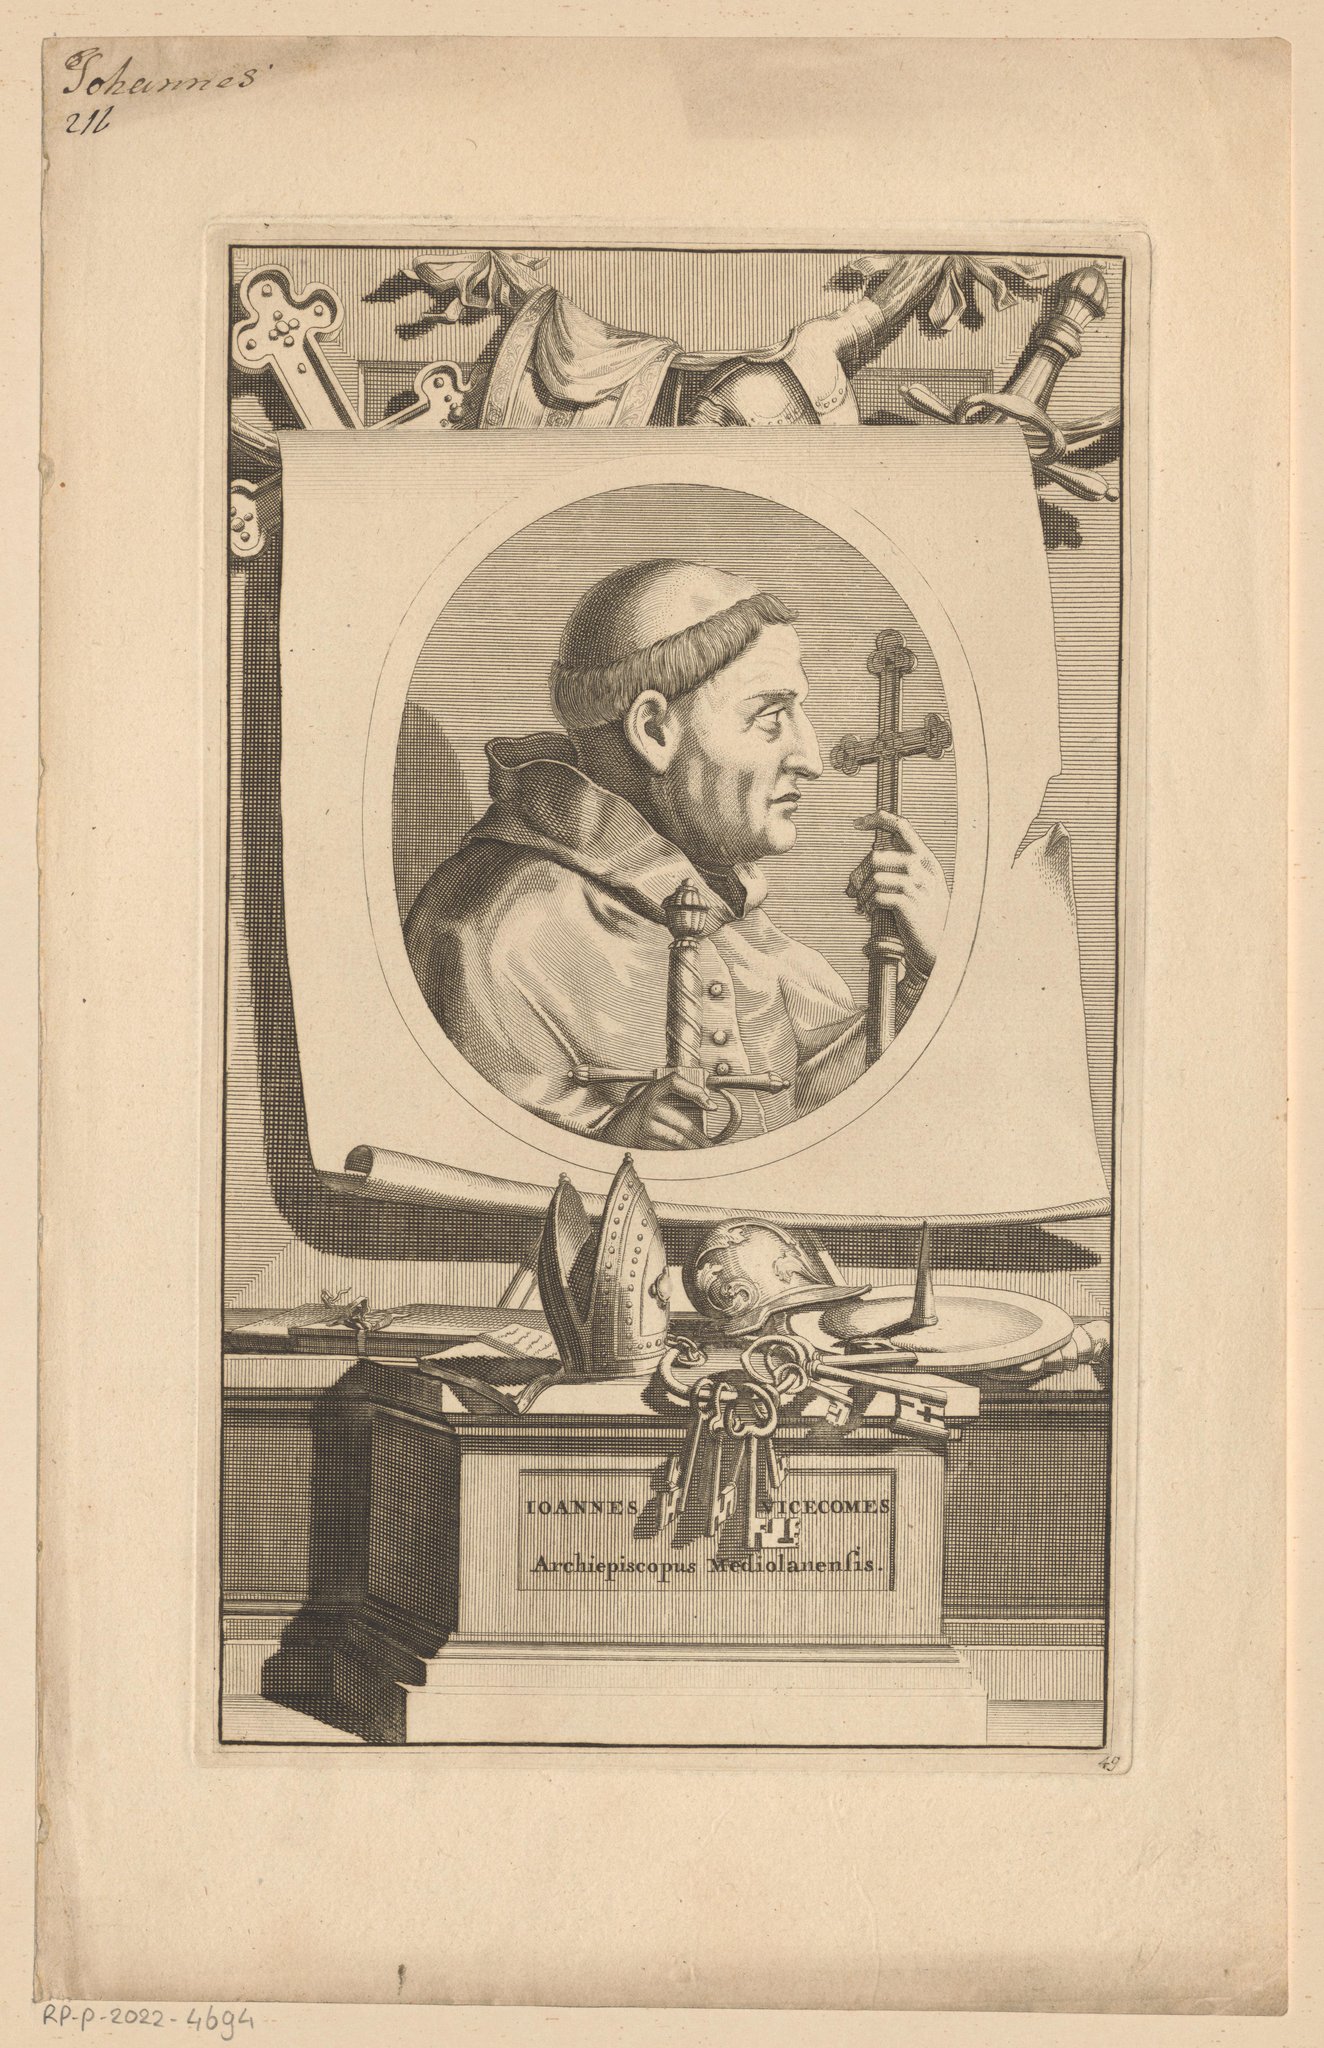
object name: print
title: Portretten van belangrijke leiders en geleerden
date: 1710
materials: paper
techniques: engraving, etching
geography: leiden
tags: priest, archbishop, bishop, etc. (roman catholic), hacking and thrusting weapons, historical persons, key, crucifix ~ personal devotion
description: Prent waarschijnlijk uit: Principum et illustrium quorundam virorum qui in Europa alibique terrarum quam fama quam eruditione celebres fuerunt, verae imagines. Leiden: Pieter van der Aa, [ca. 1710]. Prent mogelijk ook gebruikt in: Graevius, Johannes Georg. Thesaurus Antiquitatum et Historiarum Italiae (...). Leiden: Pieter van der Aa, 1722, dl. 1-6. Eerdere staat gebruikt in de editie uit 1704.